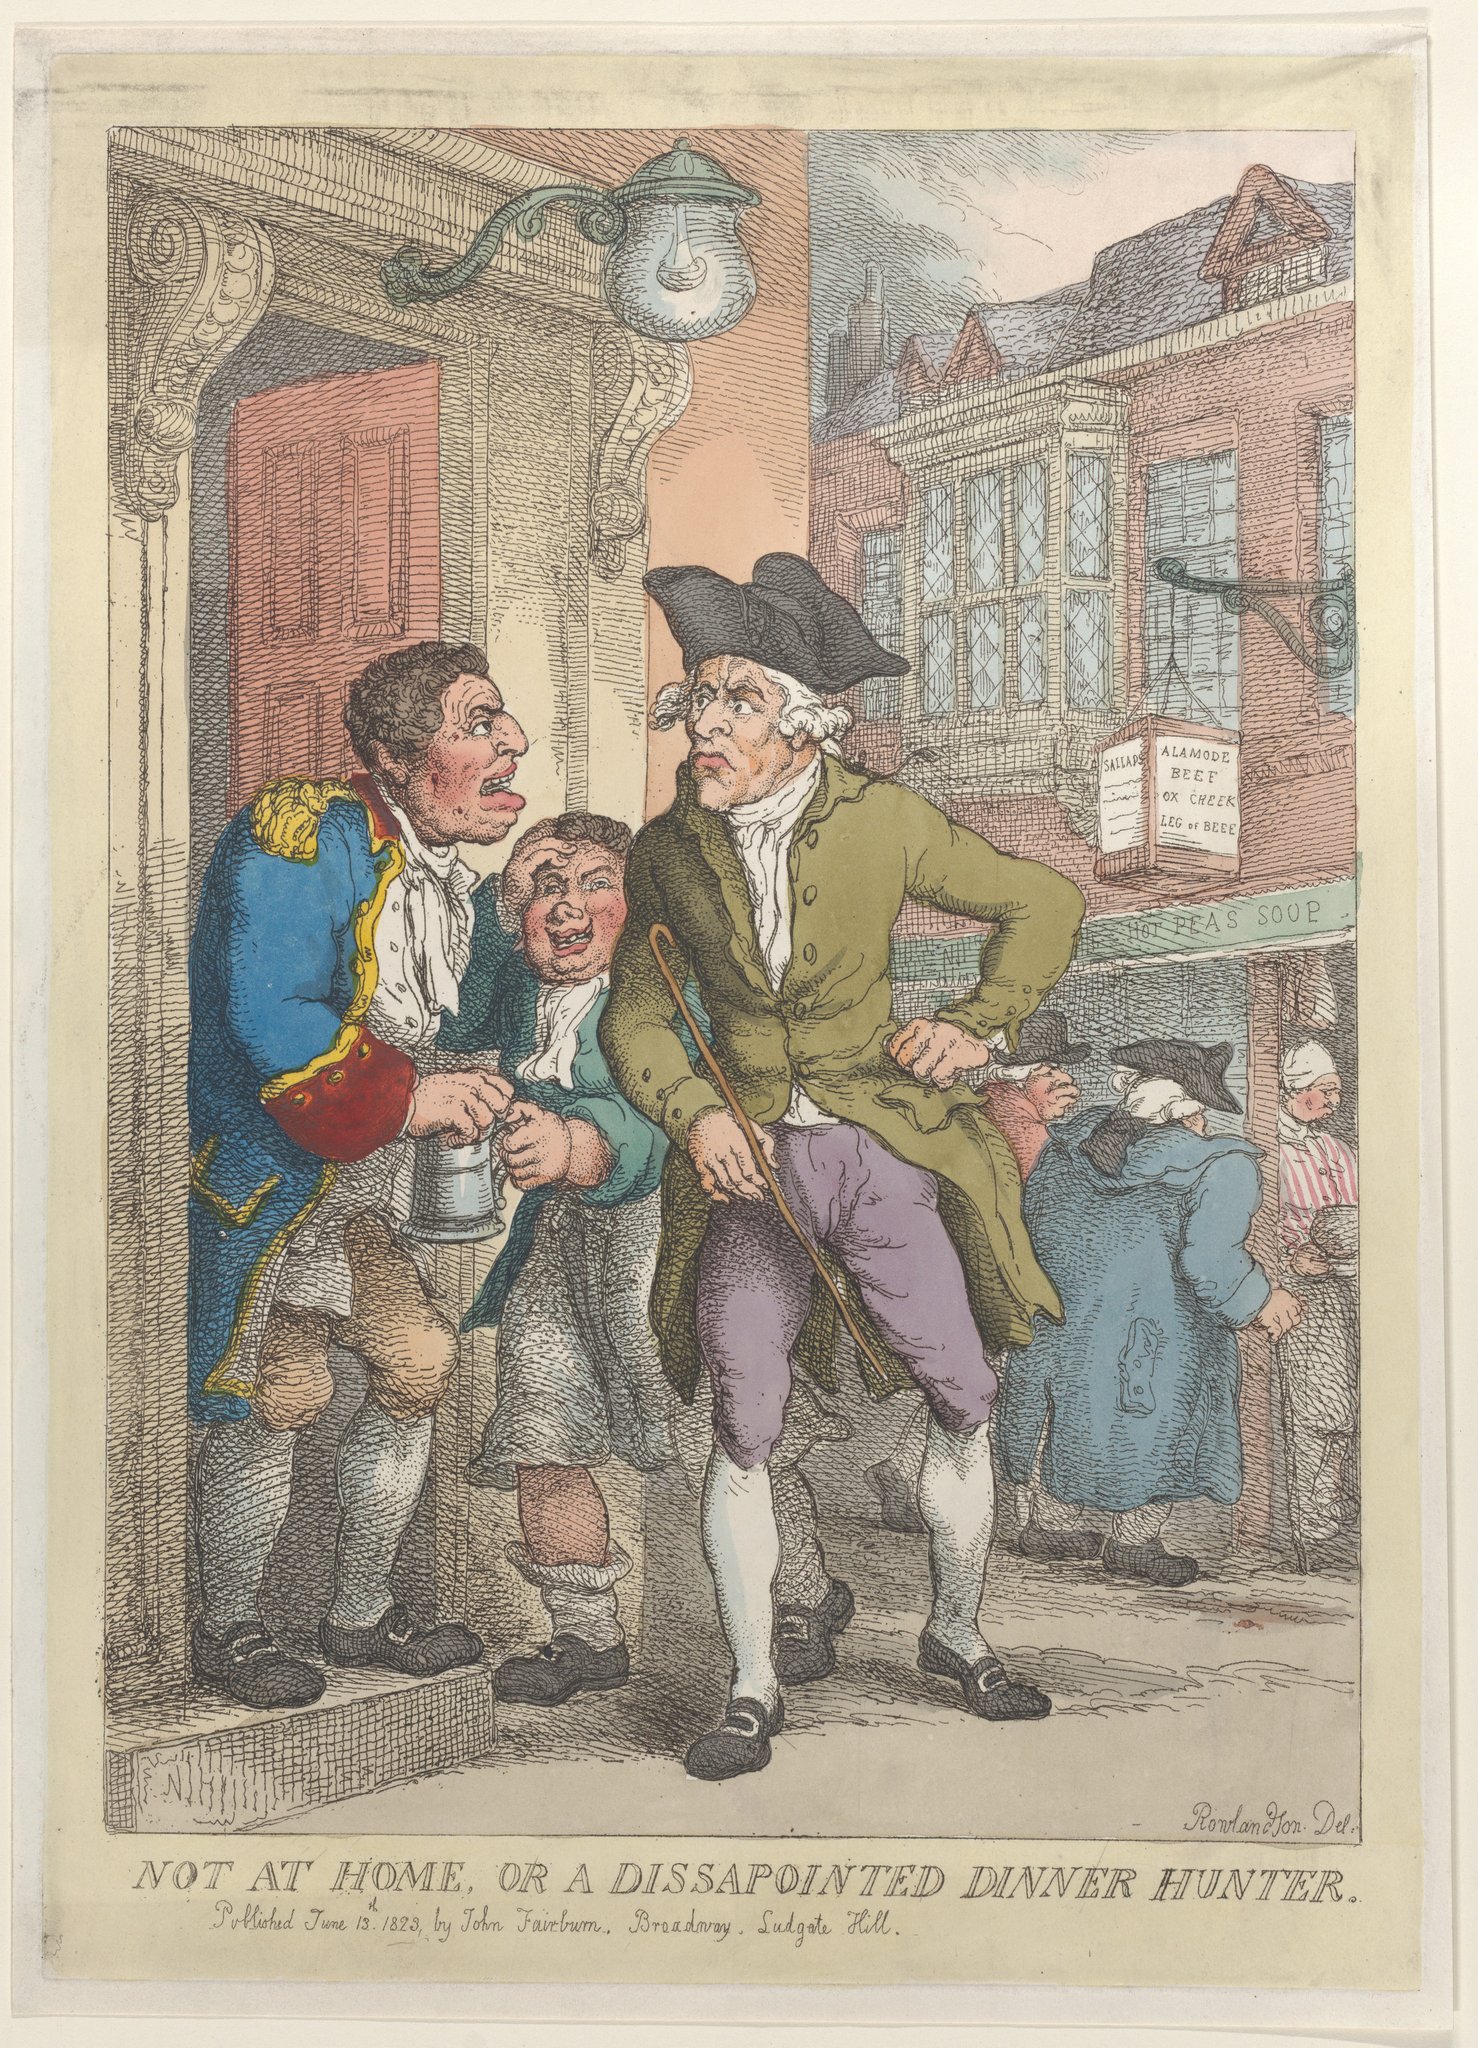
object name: print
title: Not at Home, or a Disappointed Dinner Hunter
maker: thomas rowlandson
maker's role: artist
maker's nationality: british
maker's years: 1757-1827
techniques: etching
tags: satire,men